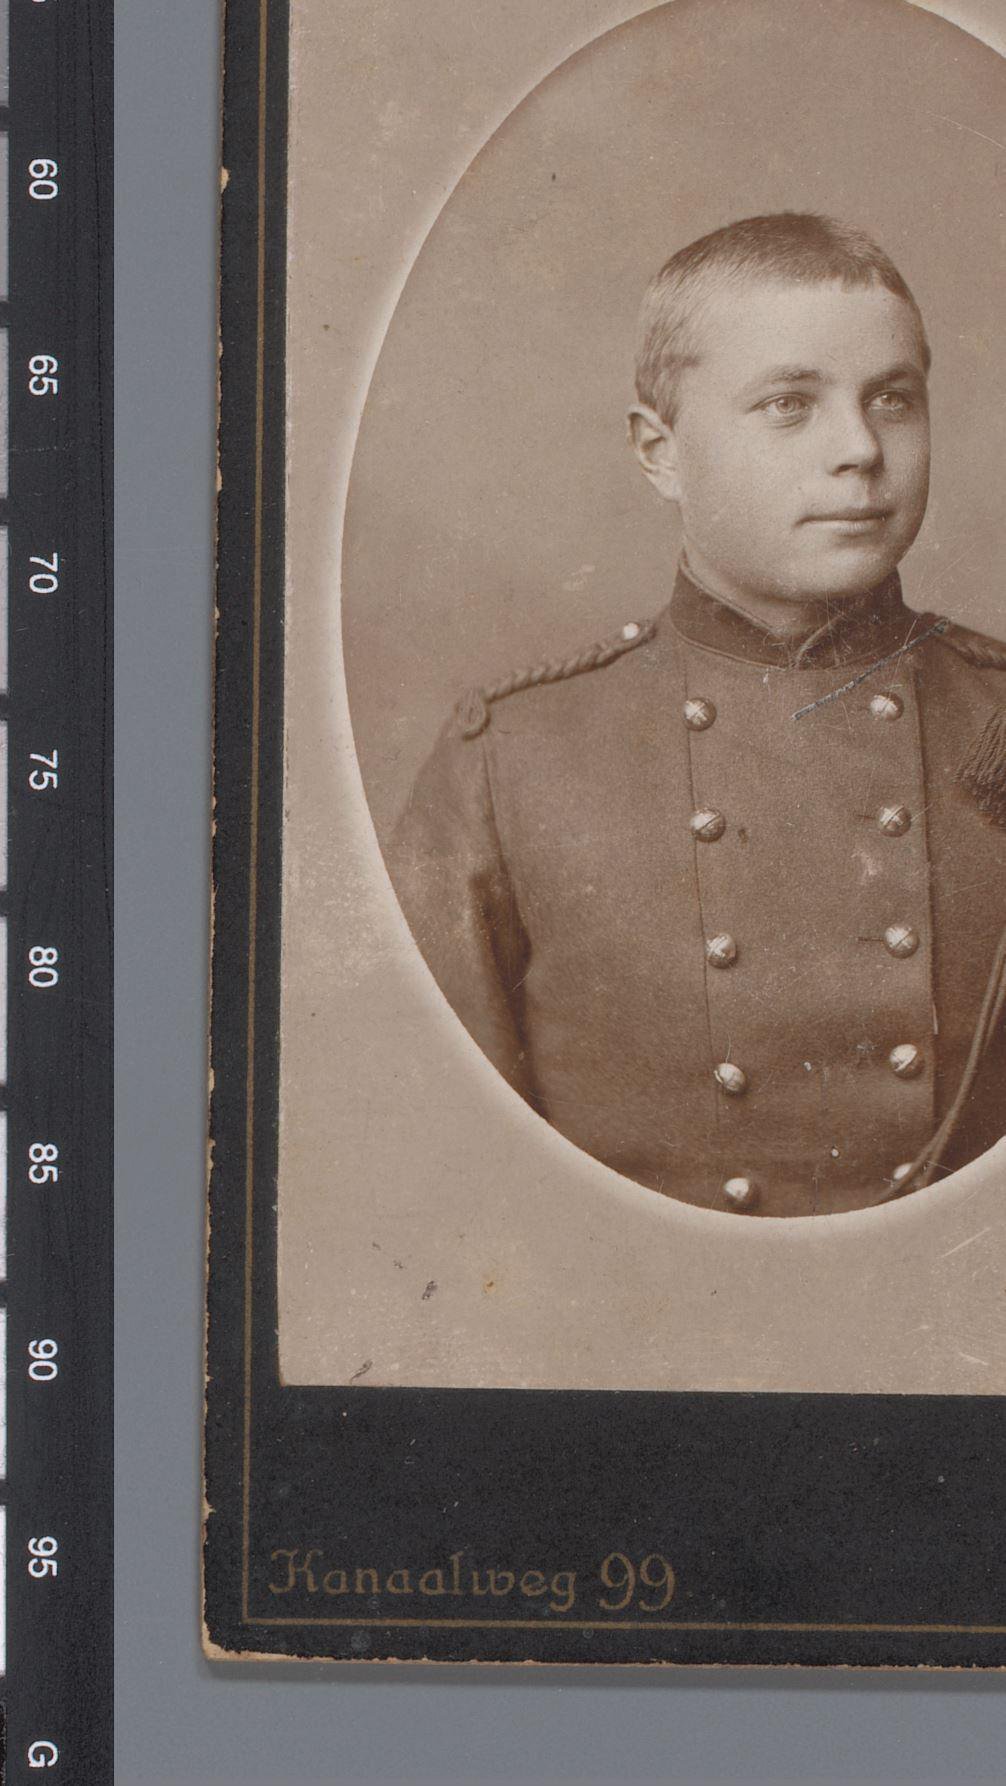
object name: photograph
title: Portret van een onbekende jonge man in uniform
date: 1880-1895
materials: paper, cardboard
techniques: collodion silver print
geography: nieuwediep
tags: youth, adolescent, anonymous historical person portrayed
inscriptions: inscription: ‘Photographie/ de/ Alkmaar./ alleen des Zondags geopend.’, address: ‘Kanaalweg 99./ HELDER’